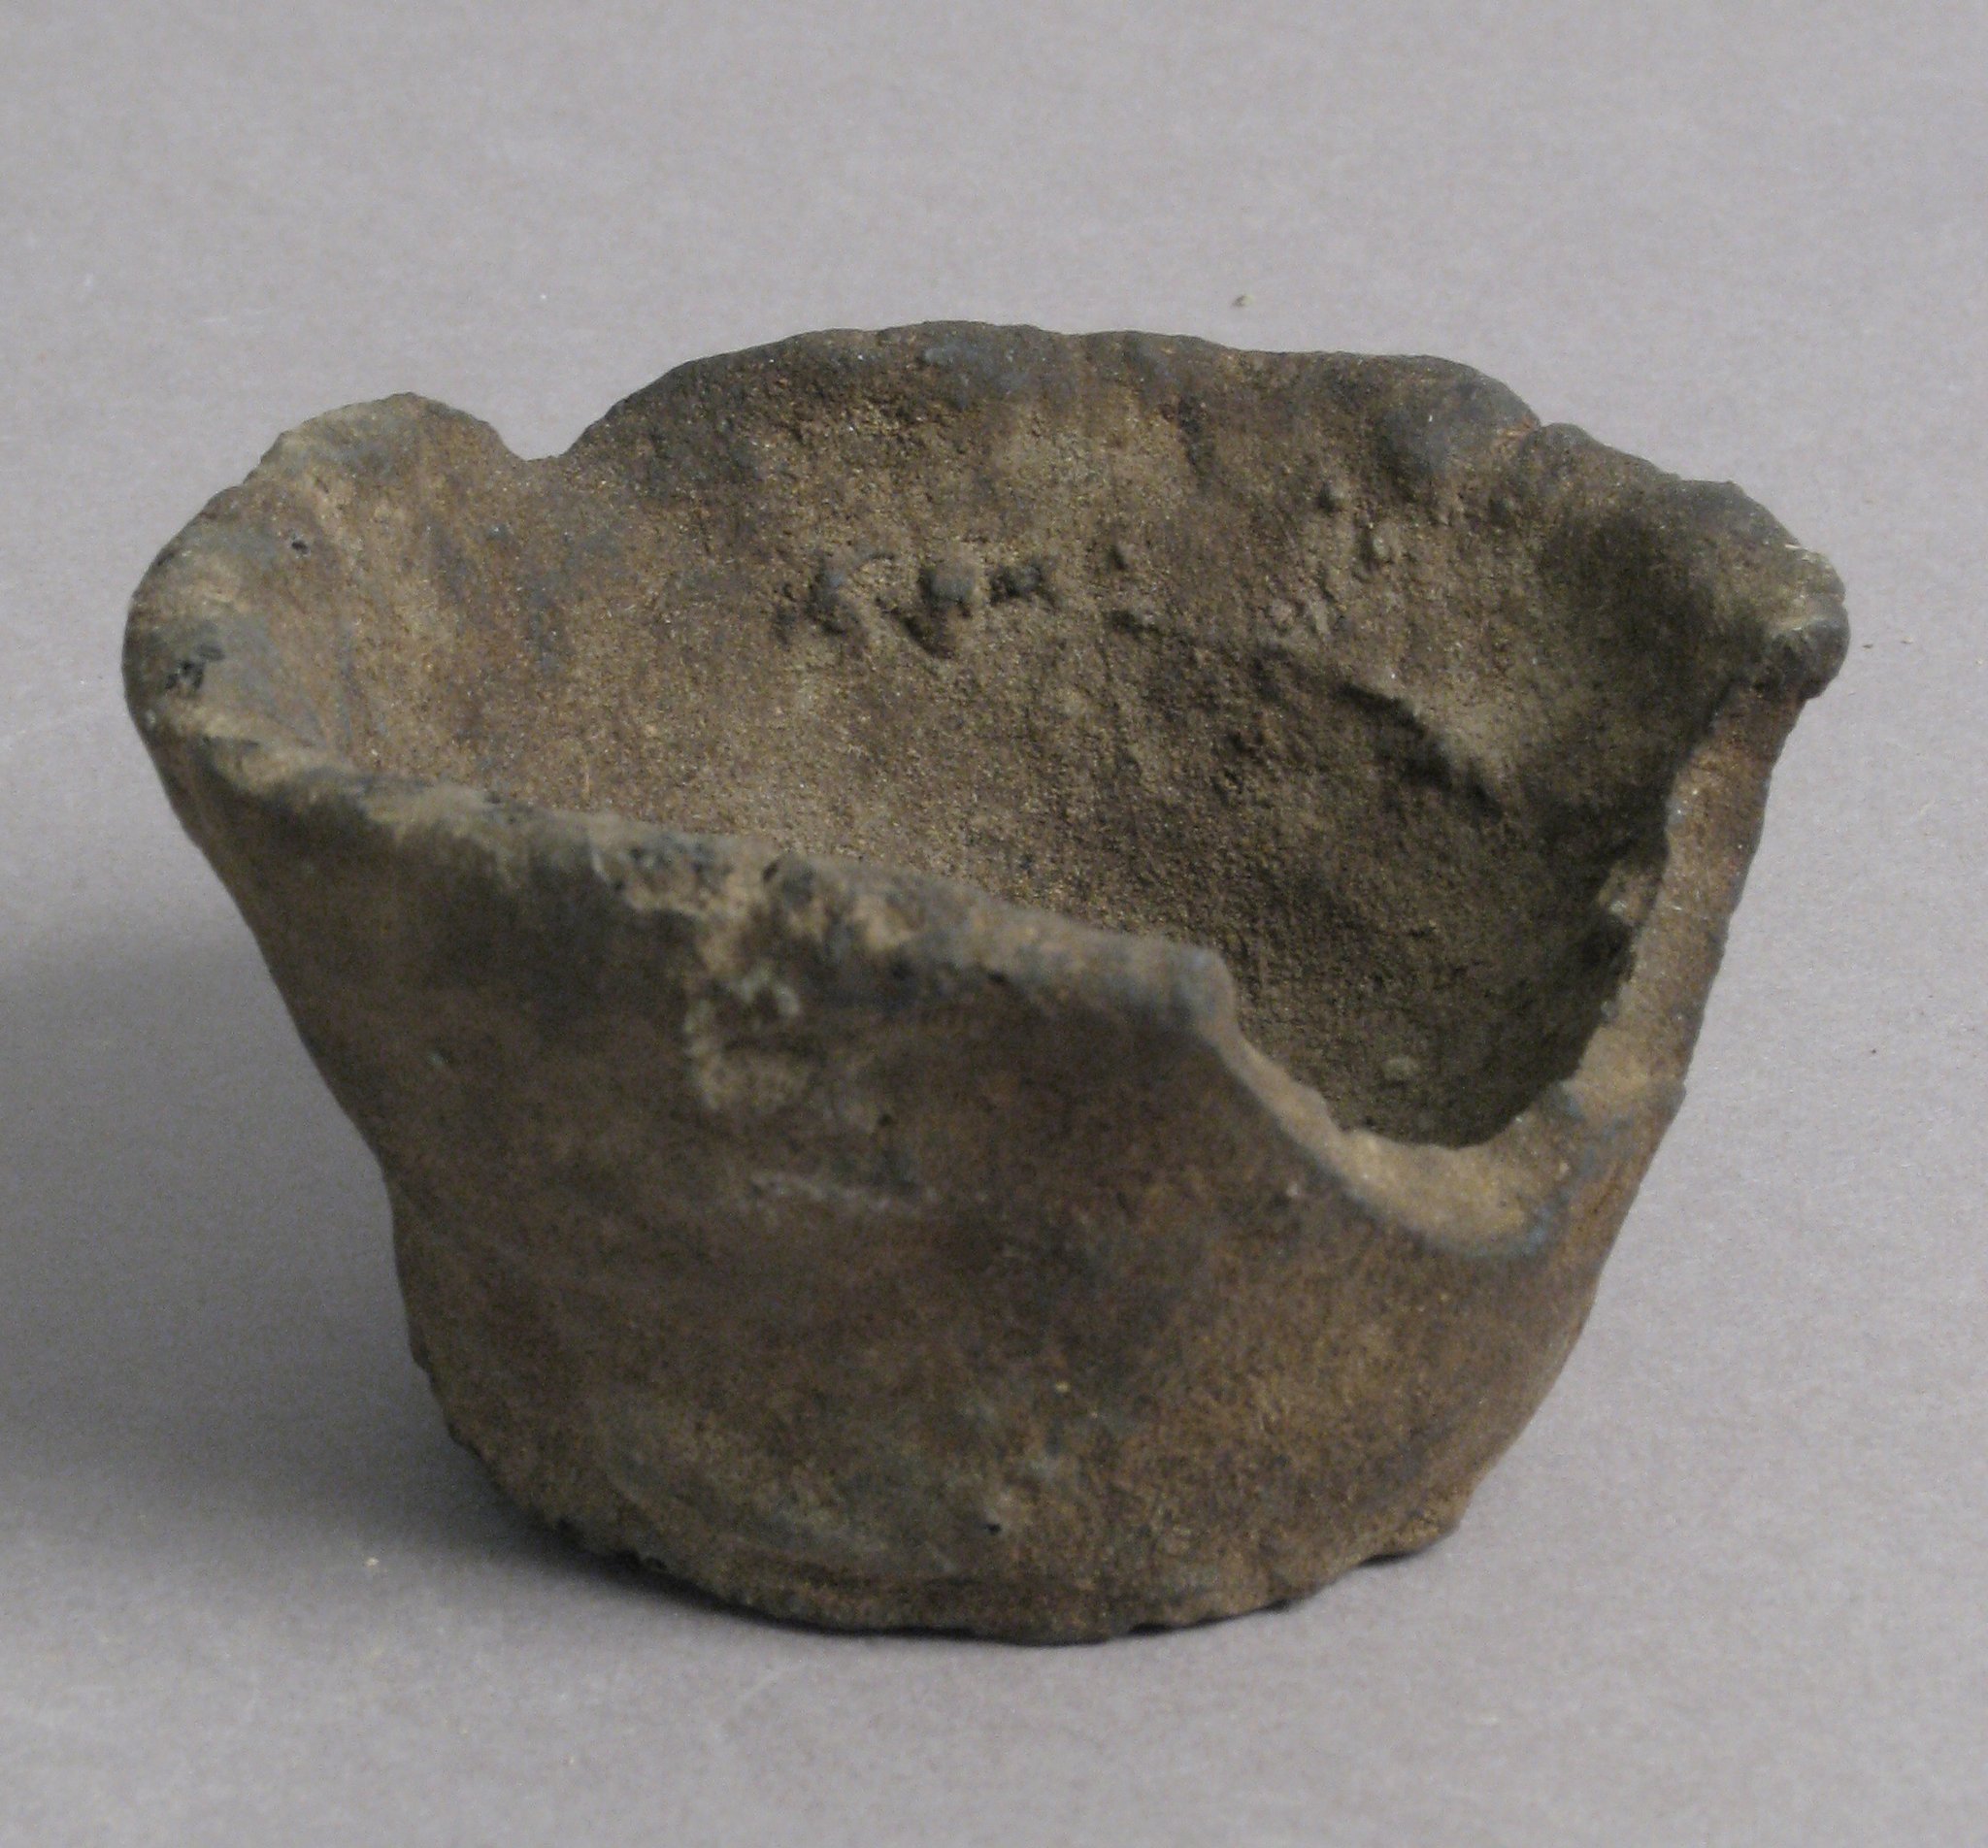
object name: dish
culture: coptic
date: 301-700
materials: earthenware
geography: egypt